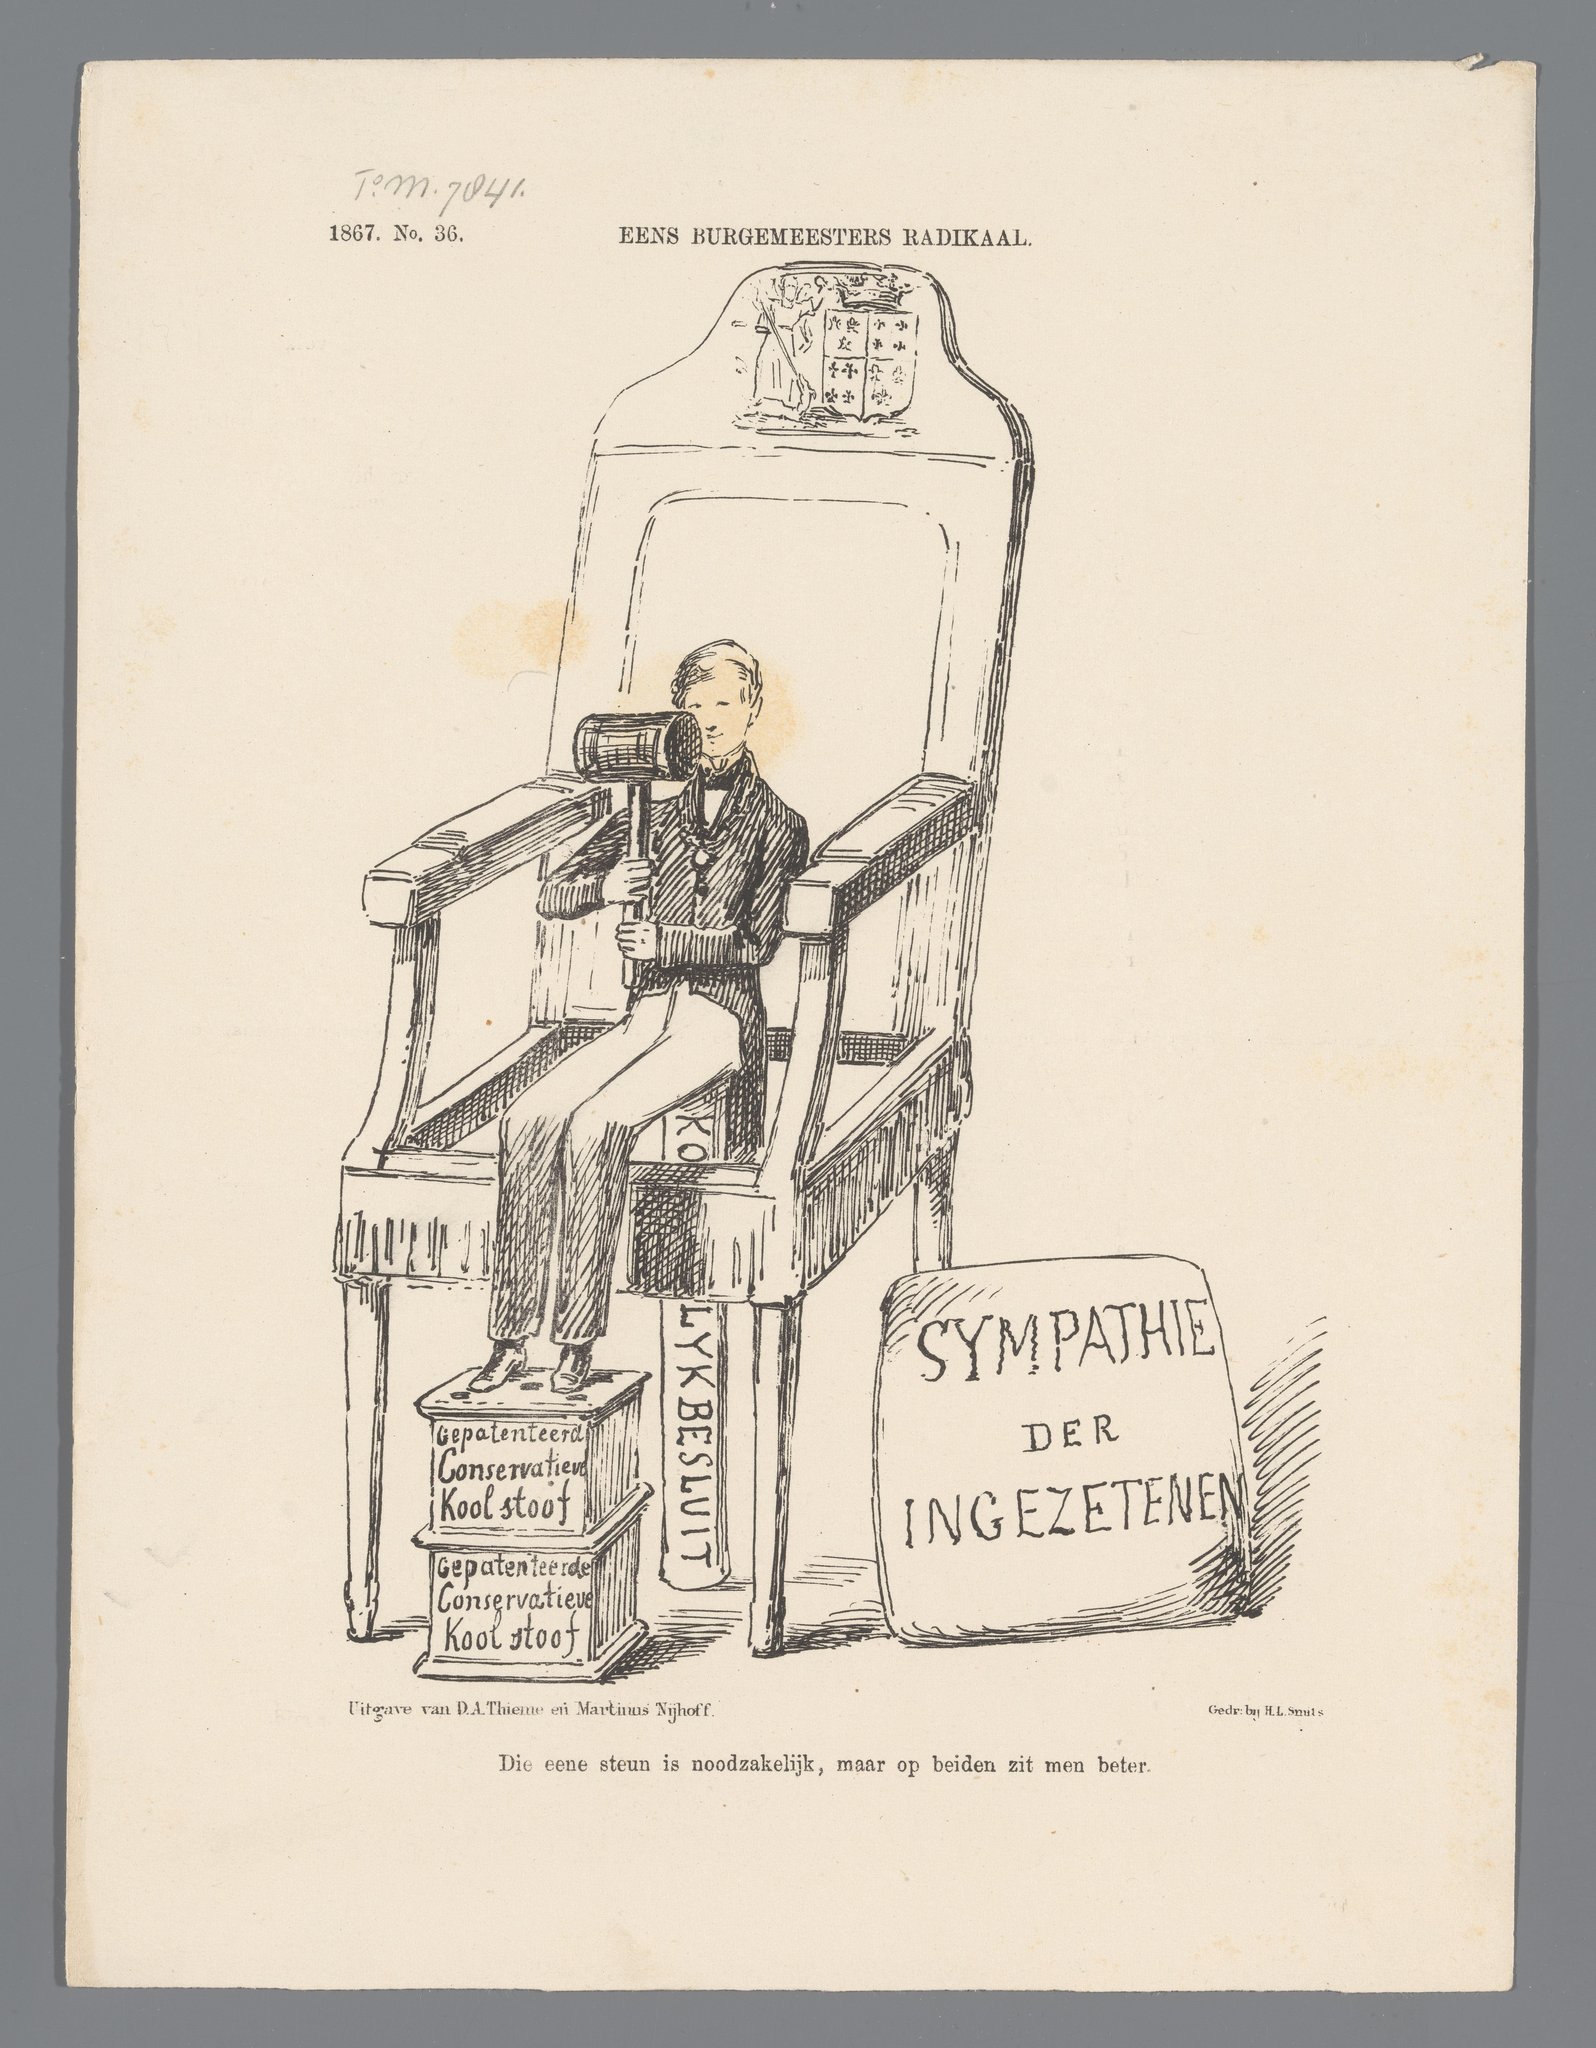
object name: cartoon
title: Eens burgemeesters radikaal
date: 1867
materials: paper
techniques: lithograph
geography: netherlands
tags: mayor, mayor, burgomaster, harlingen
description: Spotprent op de jonge nieuwbenoemde burgemeester van Harlingen, Baron van Heemstra. Klein mannetje op een grote stoel. Plaat verschenen bij het weekblad De Nederlandsche Spectator, nr. 36, 7 september 1867.